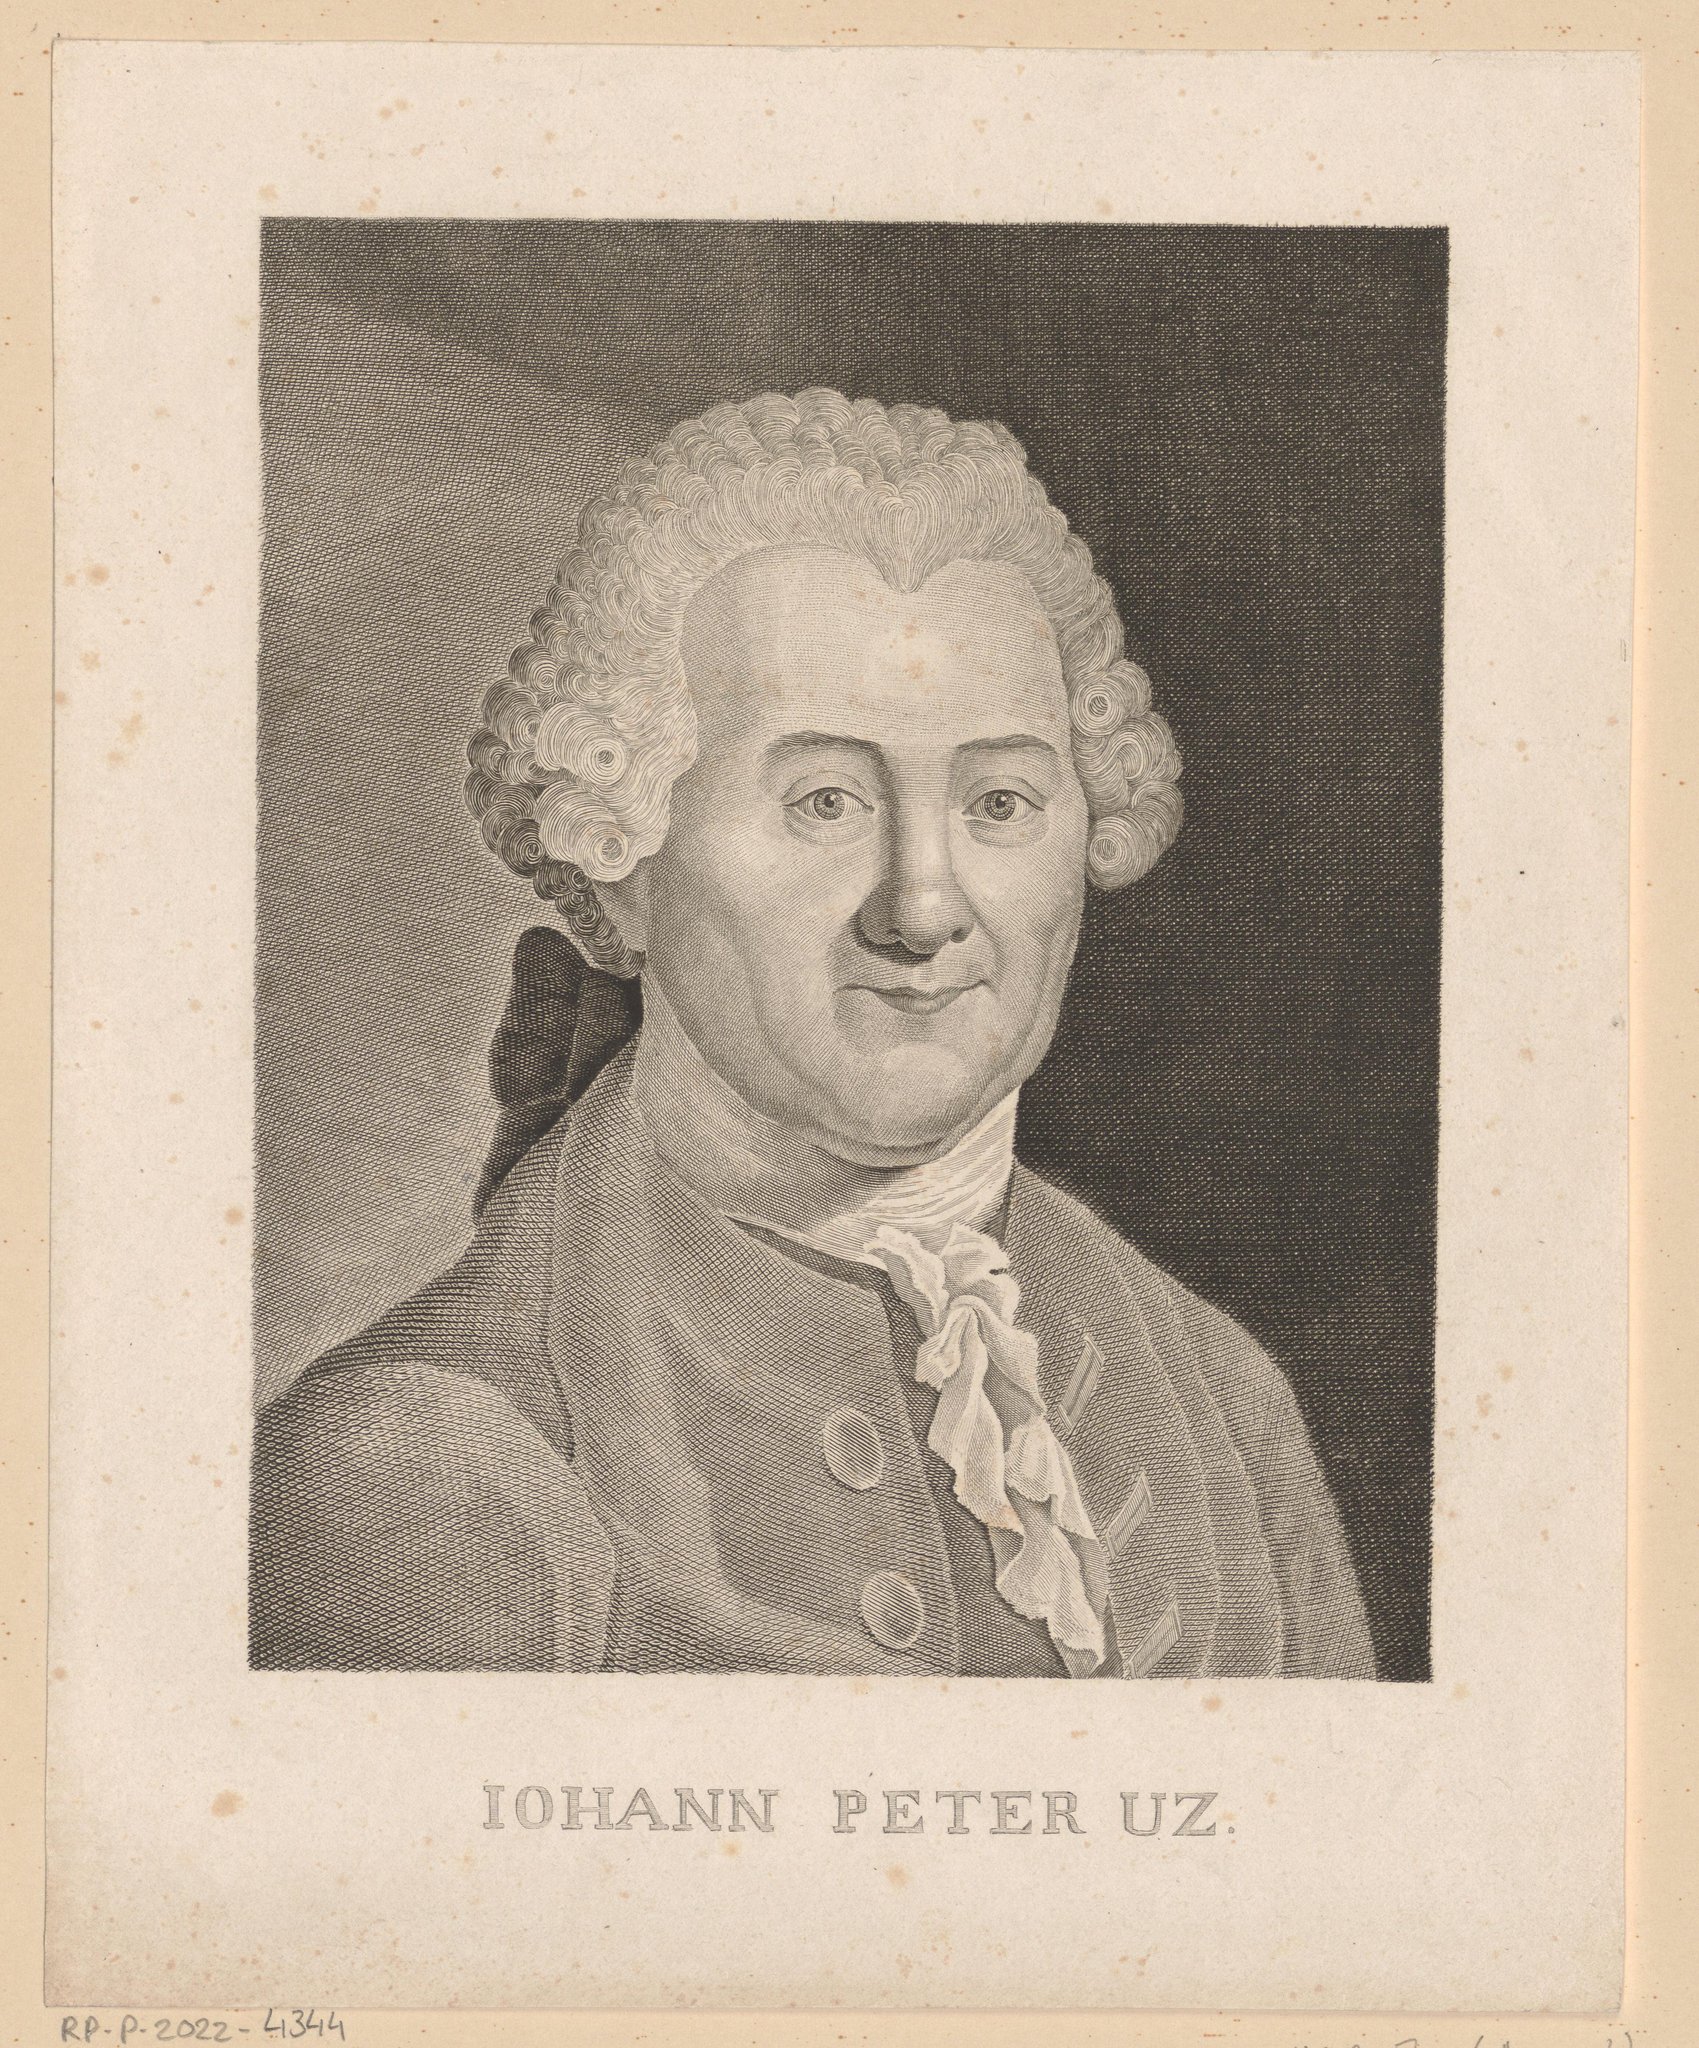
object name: print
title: Portret van Johann Peter Uz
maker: Anonymous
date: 1760-1860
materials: paper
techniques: engraving, etching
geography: germany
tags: historical persons, portrait of a writer